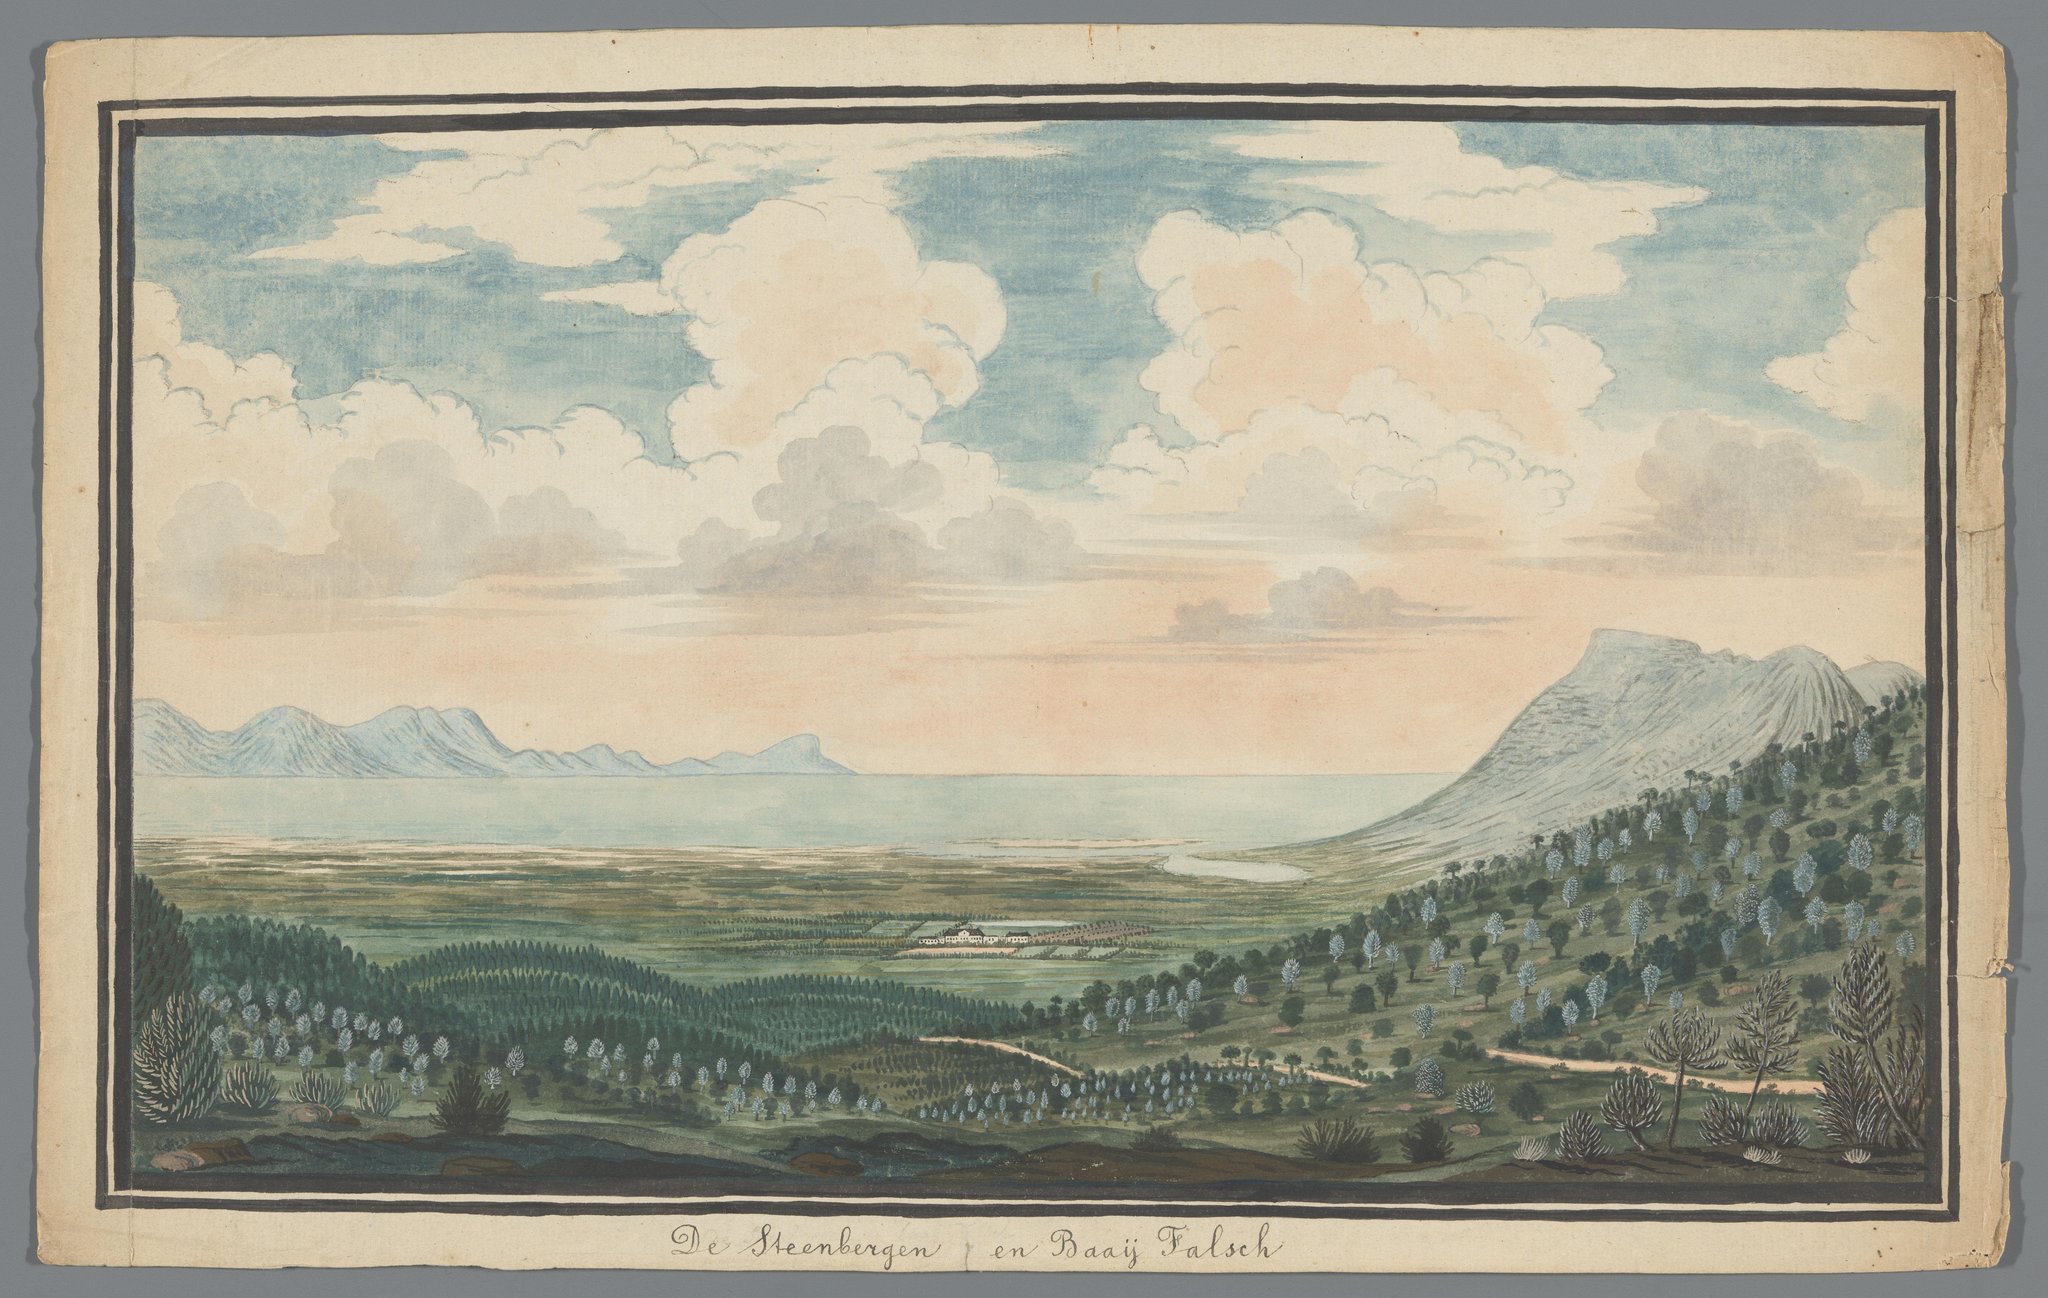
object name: drawing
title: De Steenbergen en Baaij Falsch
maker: johannes schumacher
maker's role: draughtsman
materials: paper, watercolor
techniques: brush, pen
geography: south africa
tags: cape of good hope, gulf, bay, mountain-range, snow peaks, farm or solitary house in landscape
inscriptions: label: ‘54’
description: Gezicht op de Steenbergen en de Valsbaai. In het midden een boerderij (mogelijk Swaanswijk) in de Kaapse Vlakte en op de achtergrond de Hottentots Holland Mountains. Tekening gemaakt tijdens één van de reizen van Hendrik Swellengrebel door de Kaapkolonie, tussen juli 1776 en januari 1777.